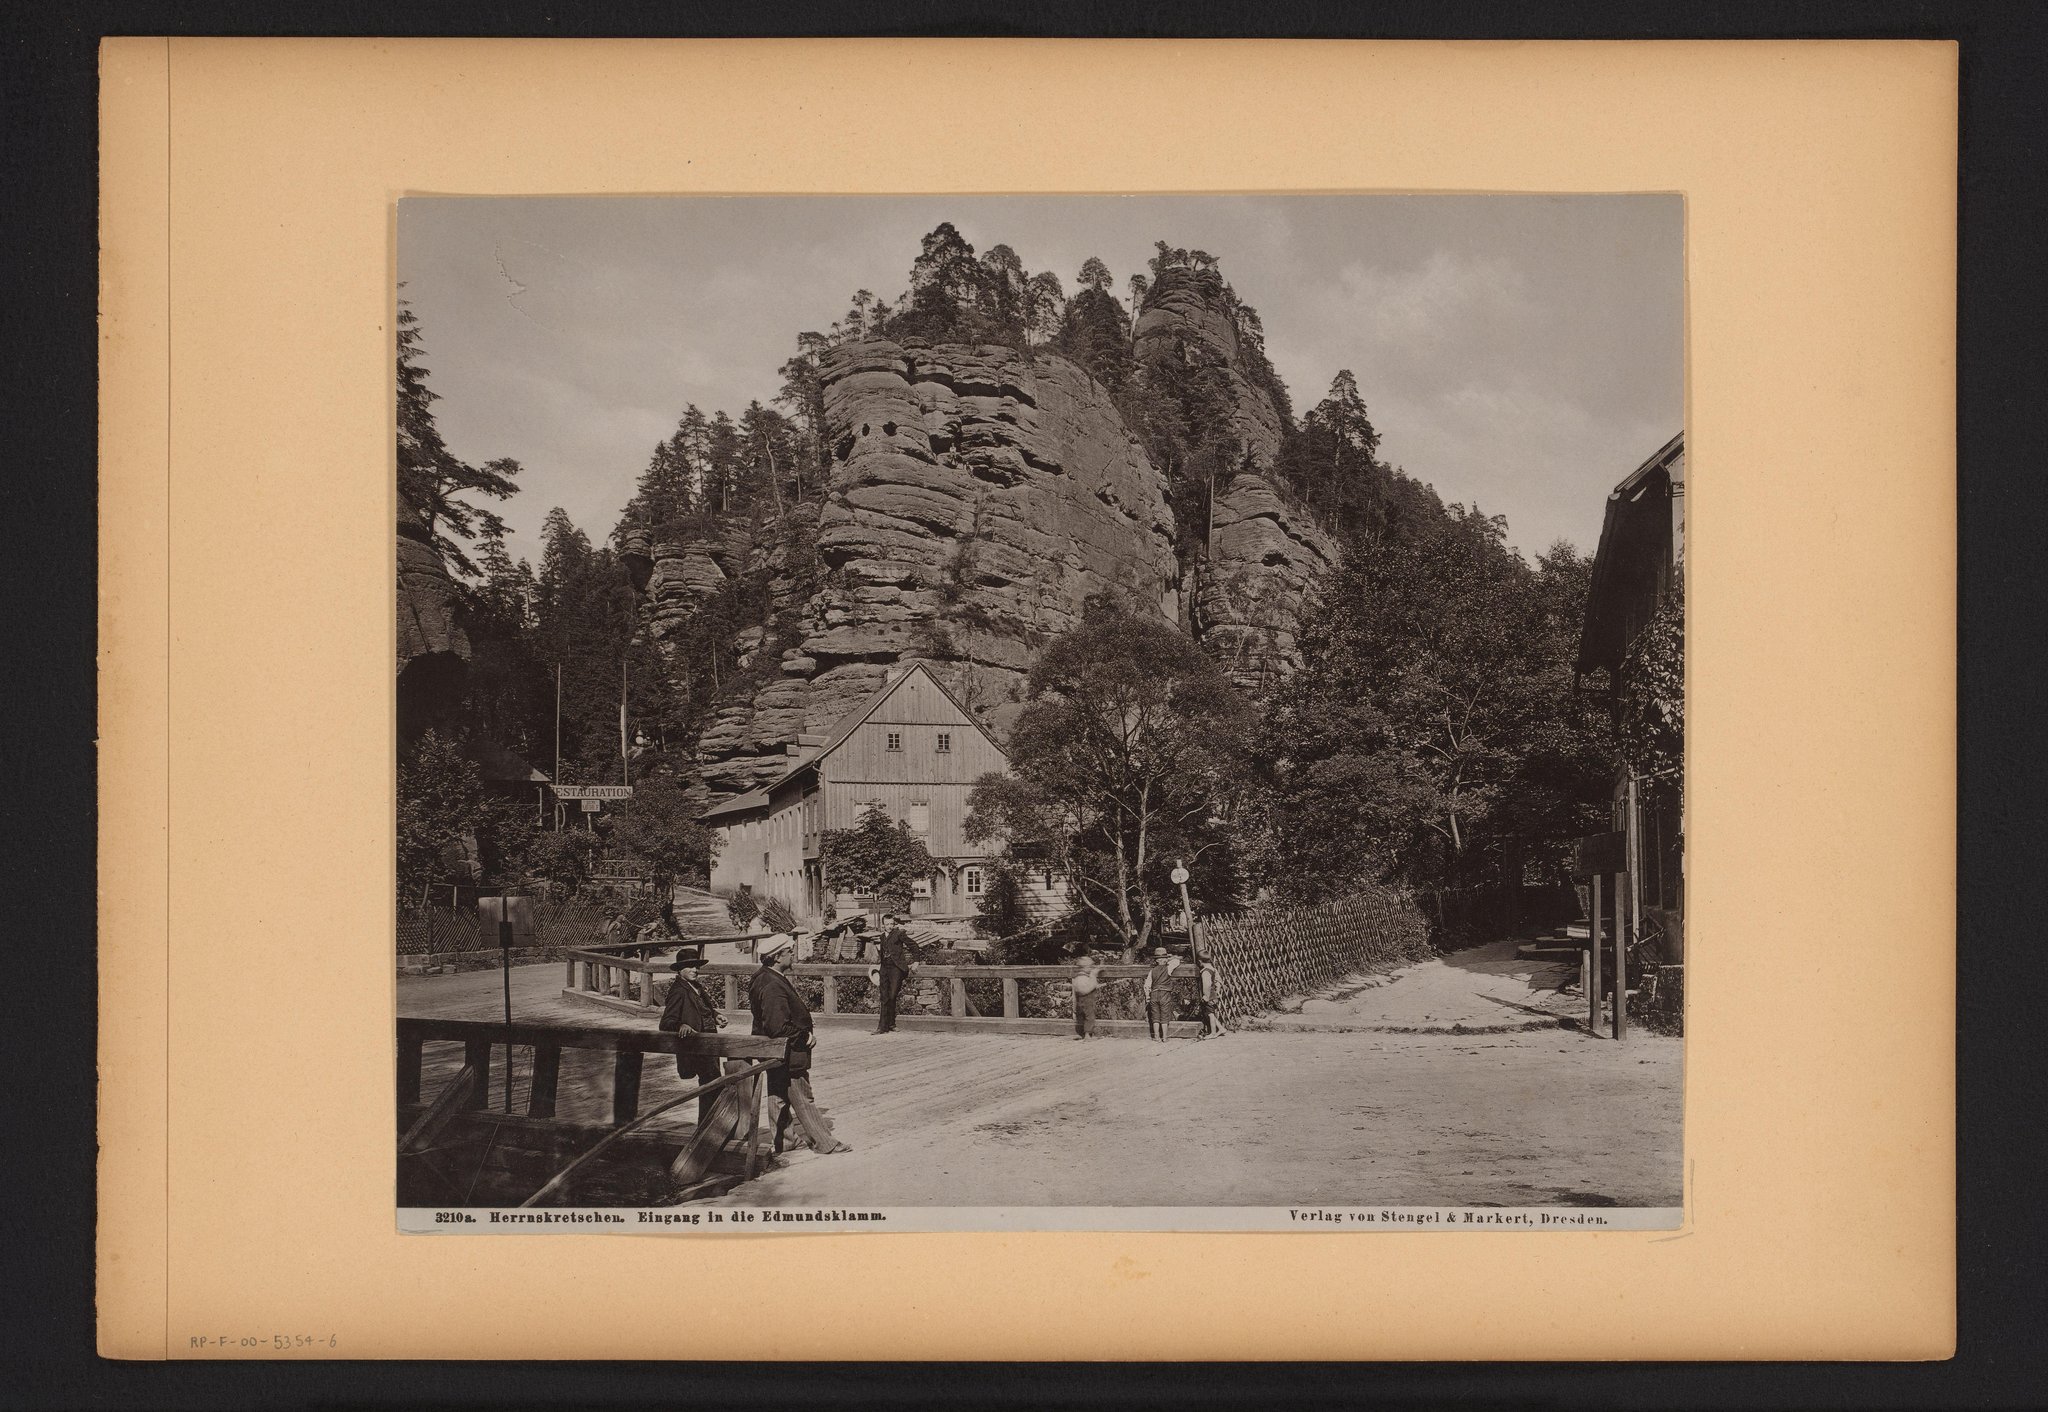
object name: photomechanical print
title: Ingang van Edmundova Souteska in Hrensko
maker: Anonymous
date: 1885-1889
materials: paper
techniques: photograph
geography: hřensko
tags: rock-formations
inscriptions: inscription: ‘Stengel & Co./ 1900/ Dresden’, inscription: ‘3210a. Herrnskretschen. Eingang in die Edmundsklamm. Verlag von Stengel & Markert, Dresden.’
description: Deze fotomechanische afdruk maakt deel uit van een omslag.